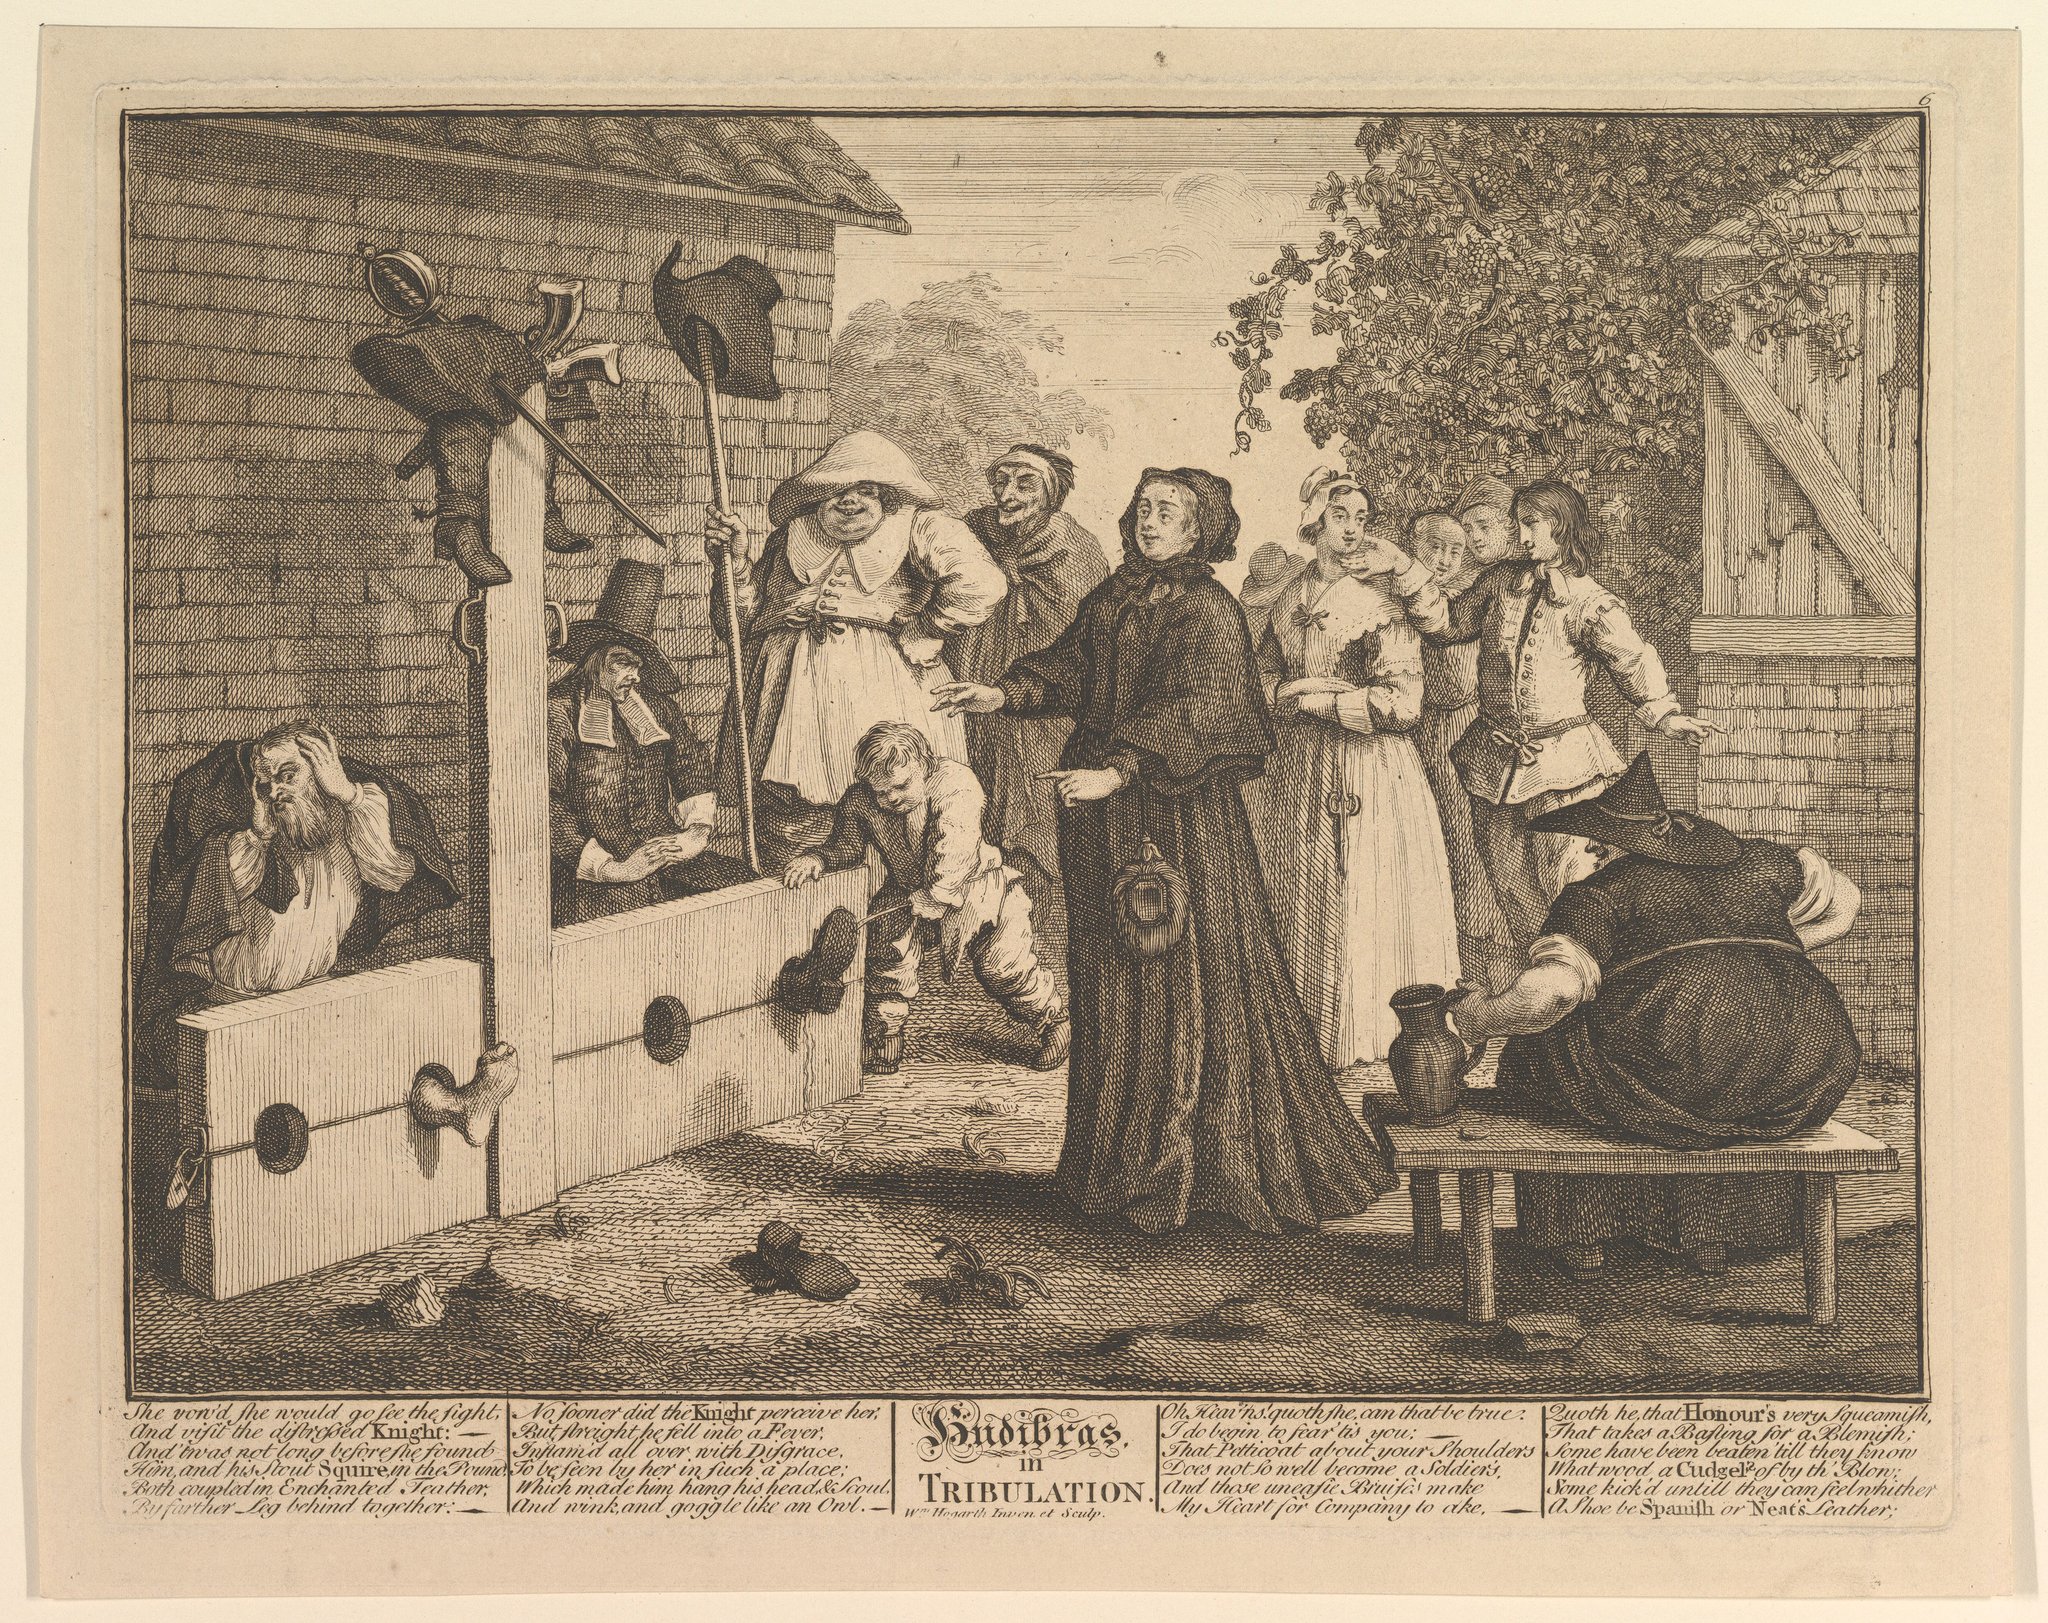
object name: print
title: Hudibras in Tribulation (Twelve Large Illustrations for Saumel Butler's Hudibras, Plate 6)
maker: william hogarth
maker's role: artist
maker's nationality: british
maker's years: 1697-1764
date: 1725-1768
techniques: engraving, etching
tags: boys,men,women,punishment